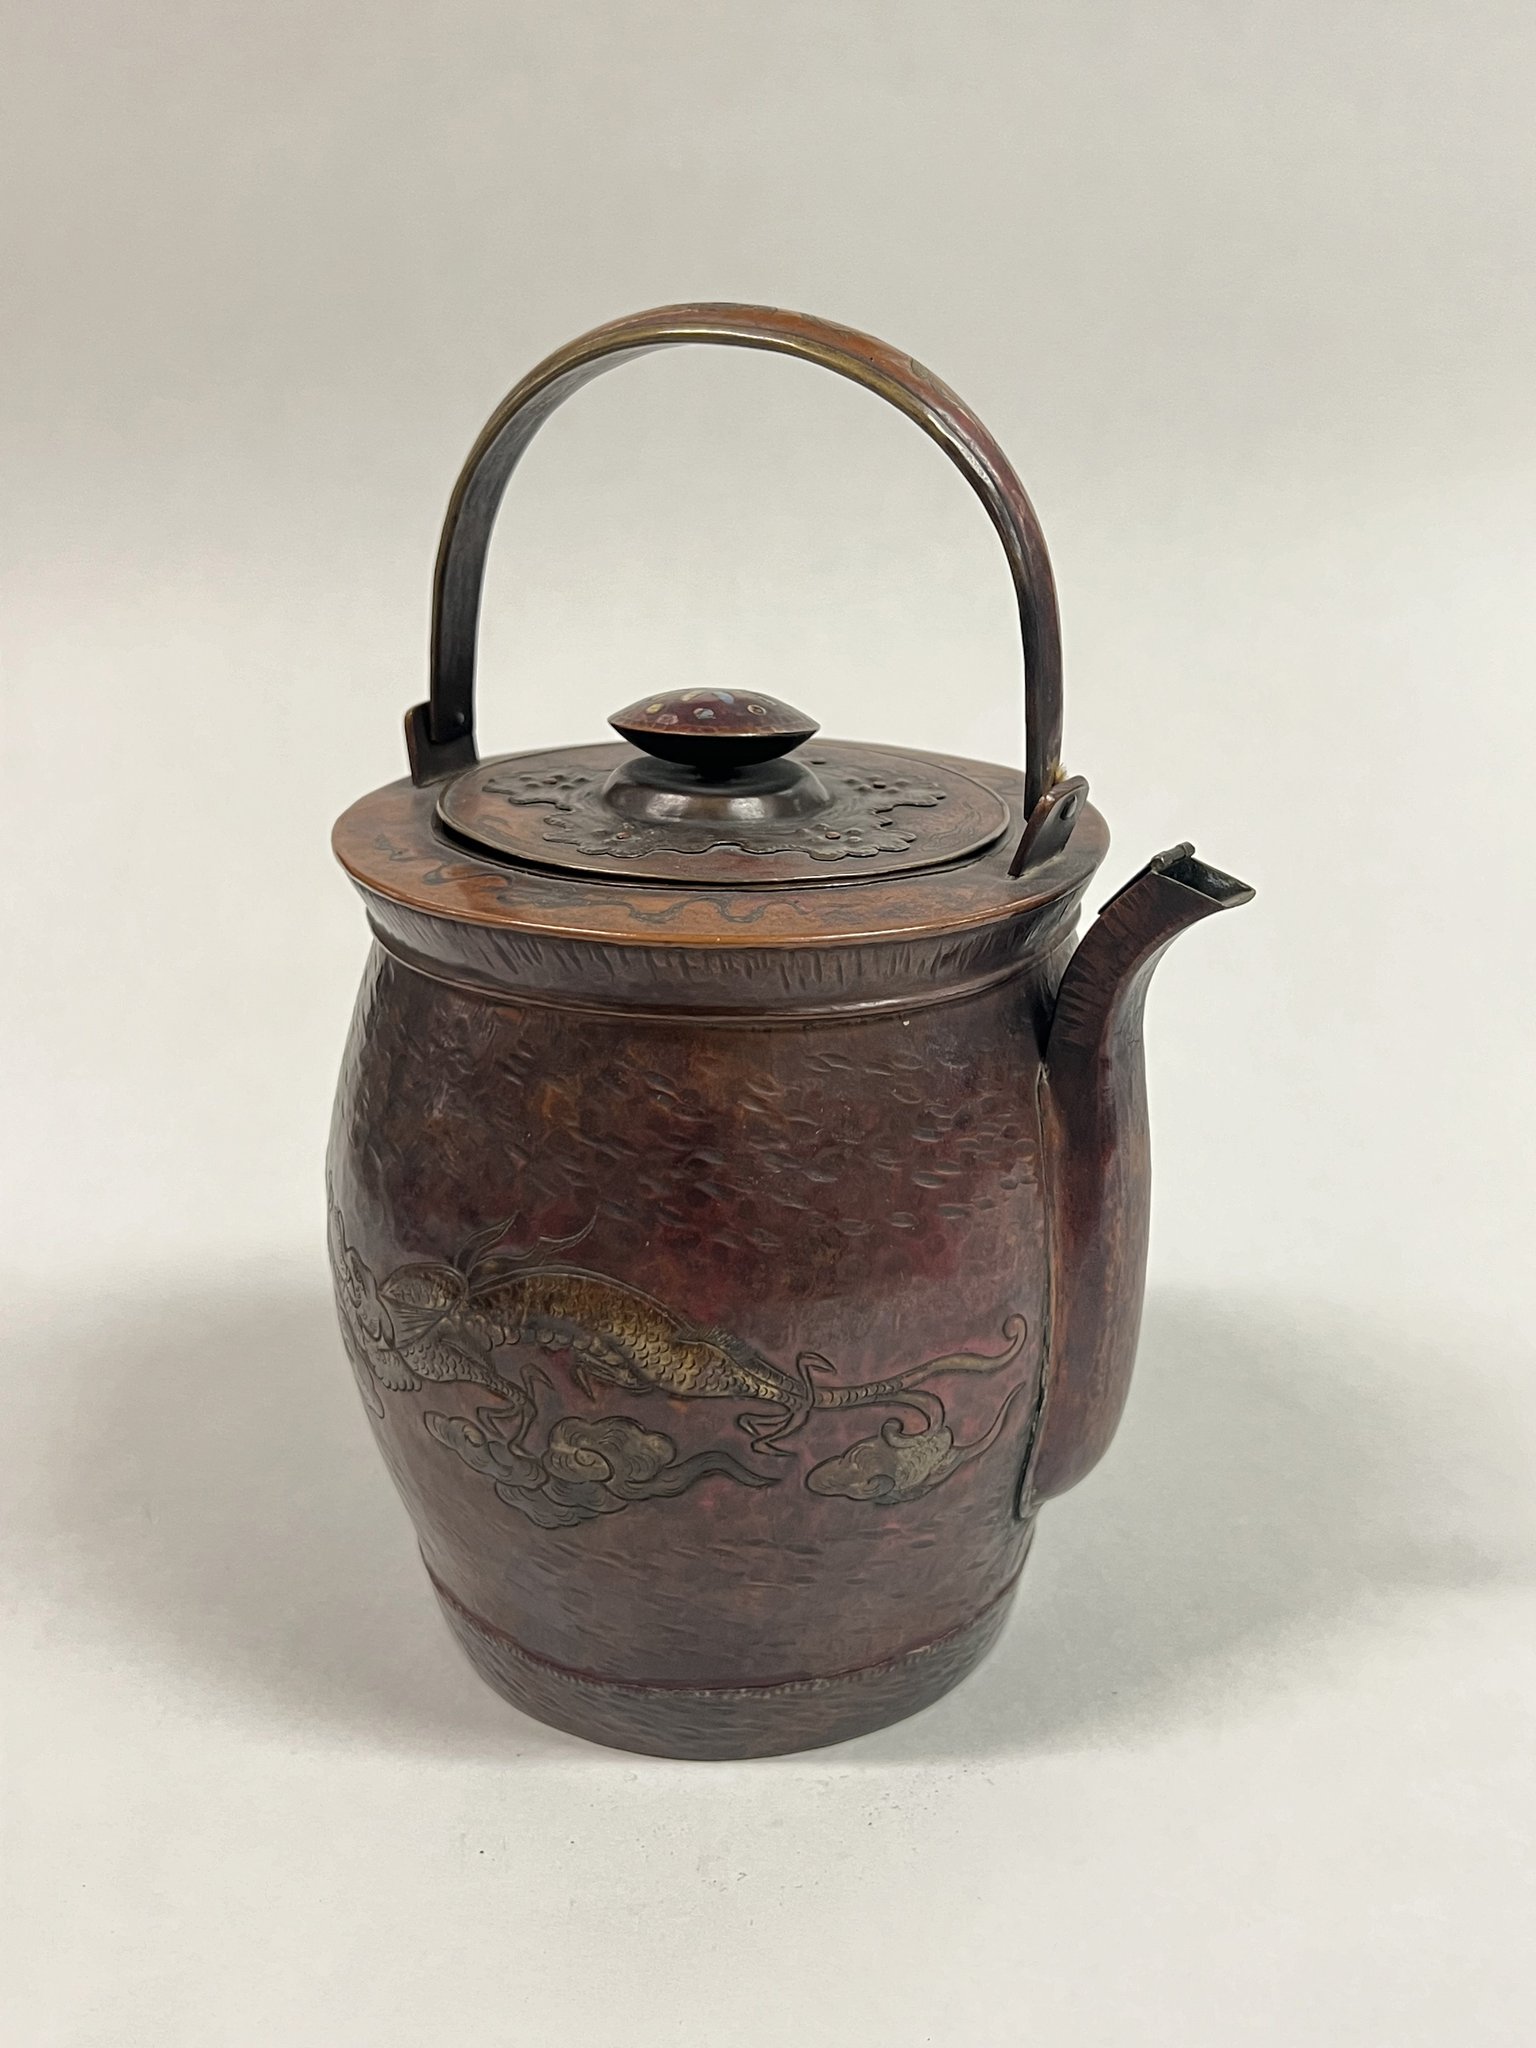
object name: kettle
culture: chinese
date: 1801-1900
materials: bronze